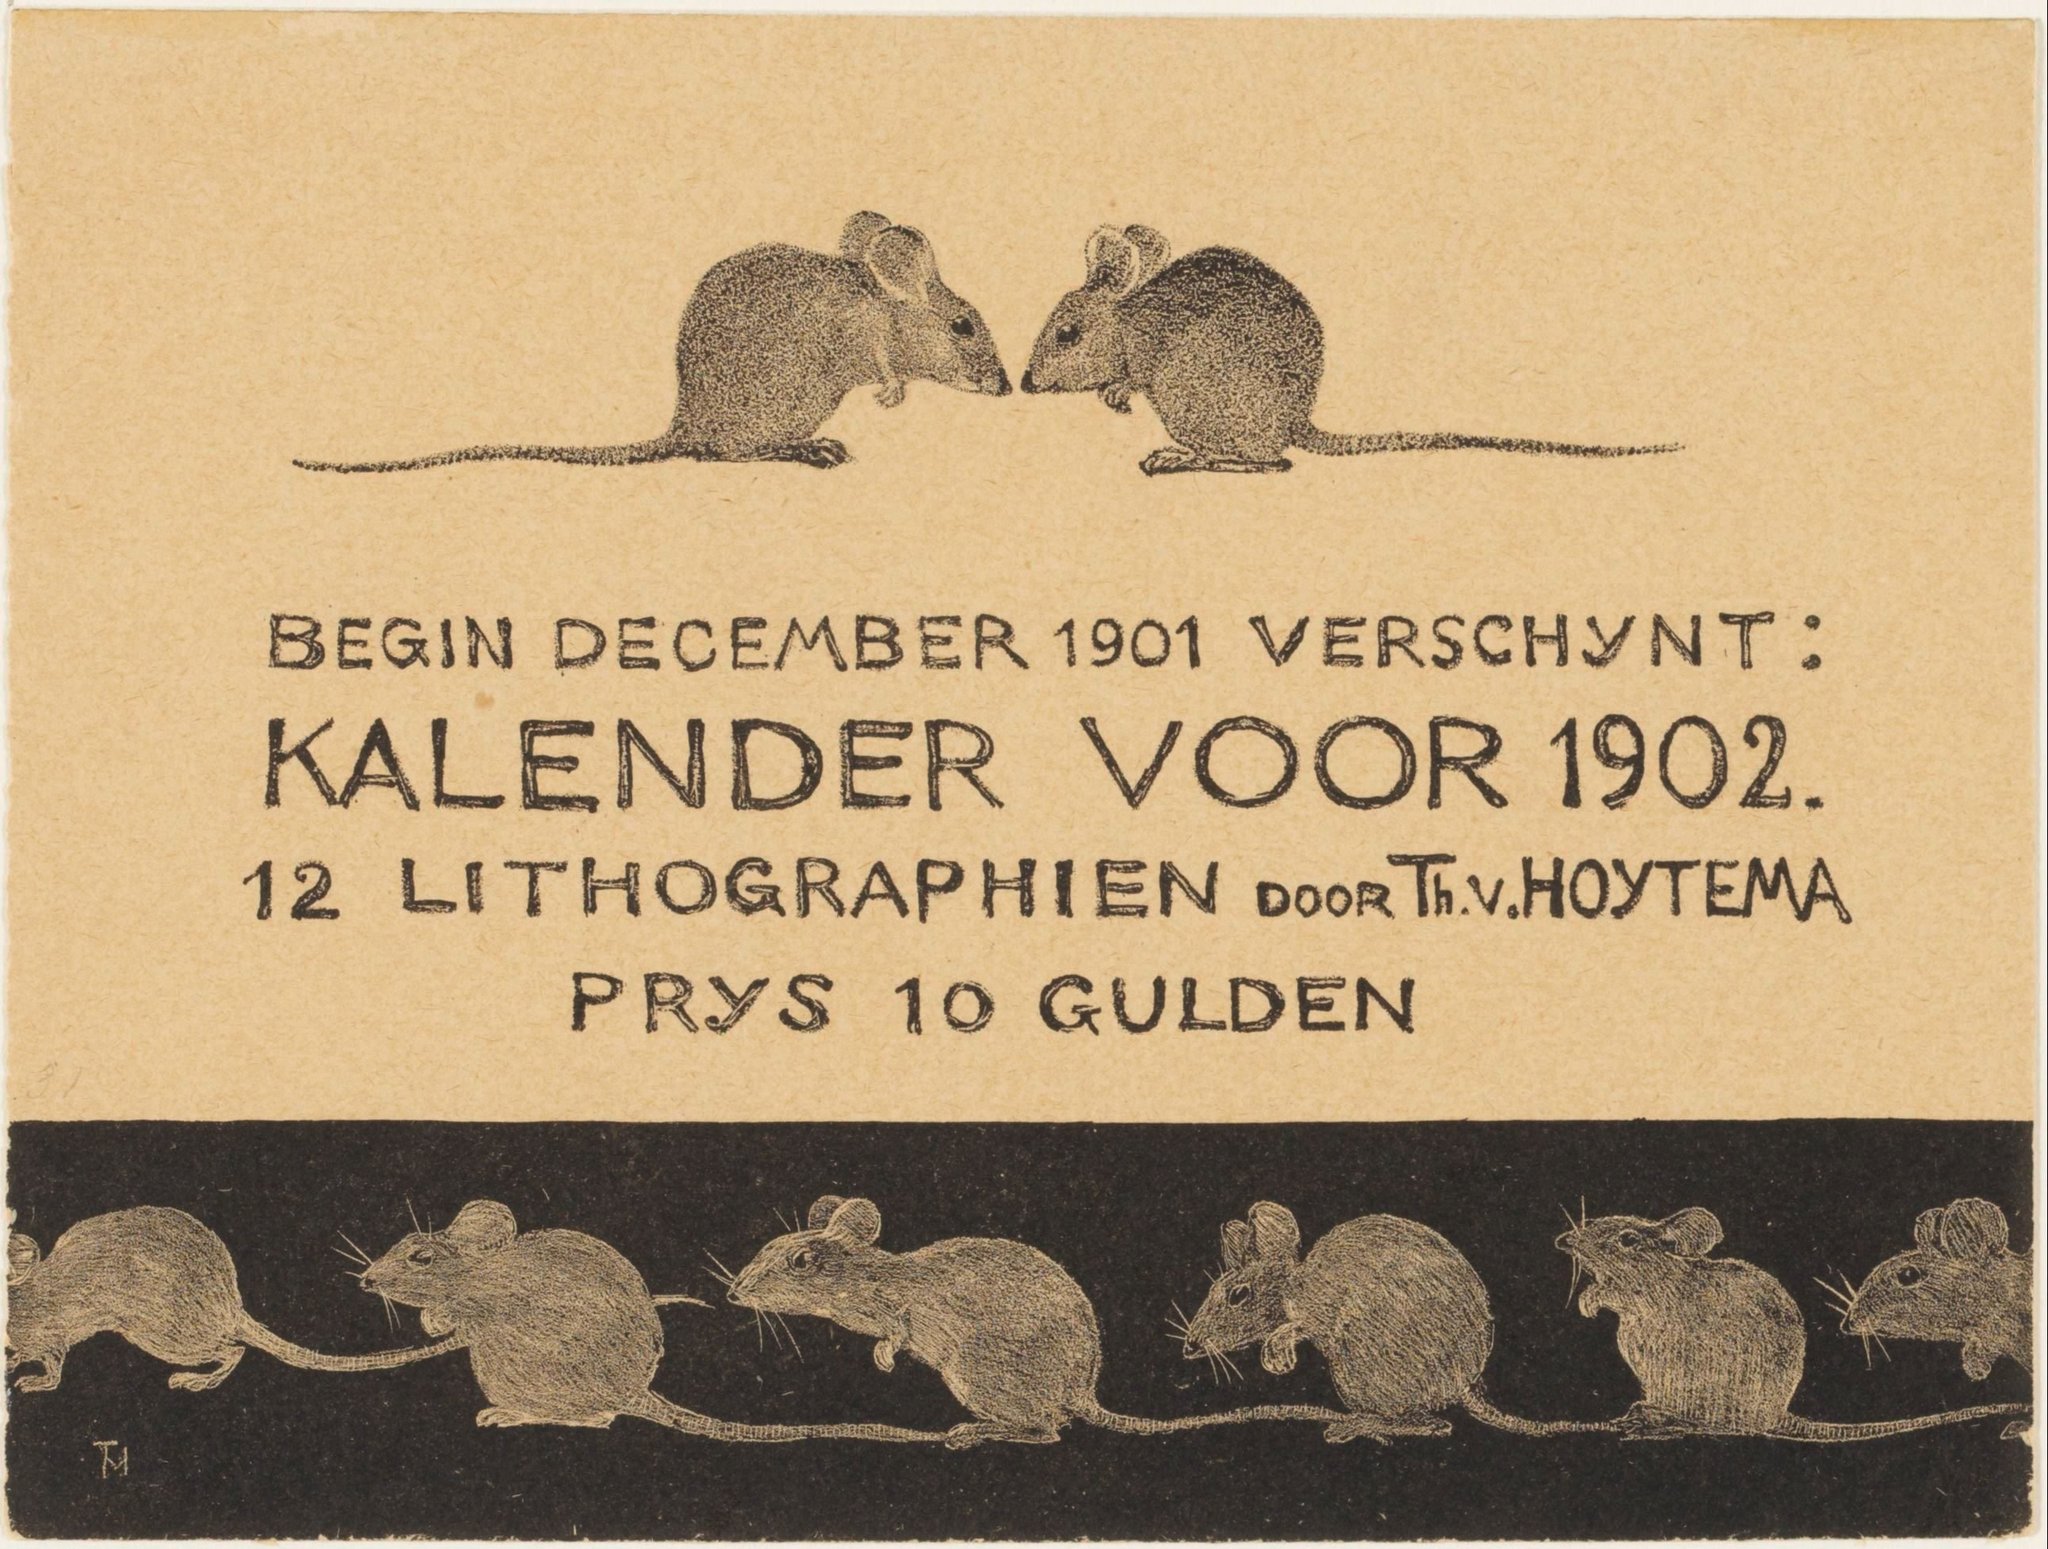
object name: print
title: Aankondiging voor kalender 1902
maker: theo van hoytema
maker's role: draughtsman, painter, print maker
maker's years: 1863-1917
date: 1878-1901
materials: paper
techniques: lithograph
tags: rodents: mouse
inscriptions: collector's mark: Lugt 2233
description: Bovenaan twee muizen; onder de tekst een donkere rand met zes muizen.